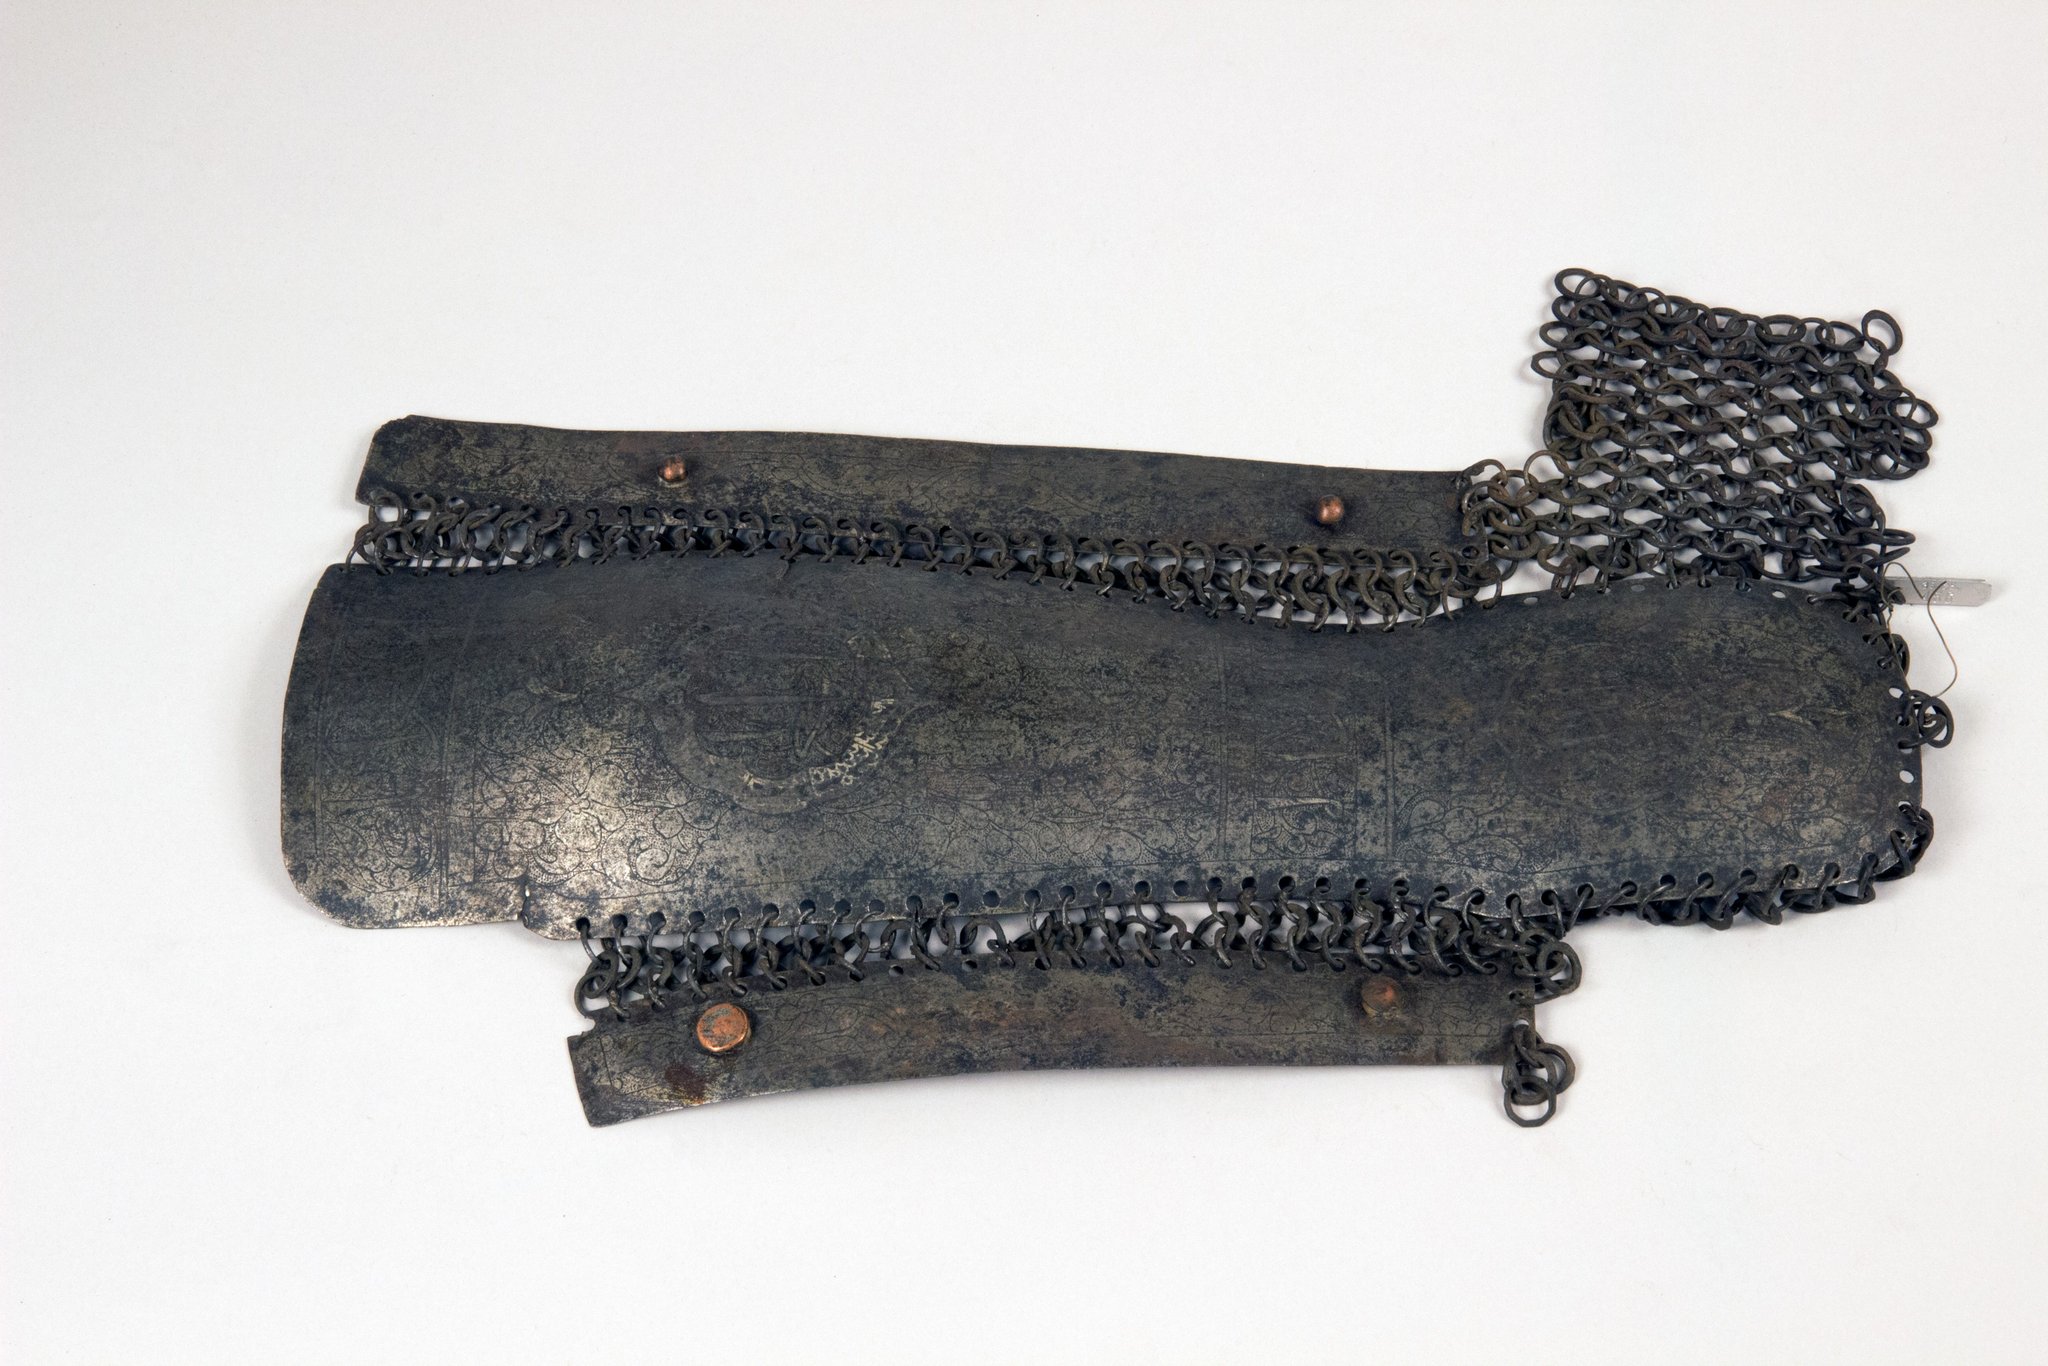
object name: leg guard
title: Left Leg Guard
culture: turkish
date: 1501-1600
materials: copper, silver, steel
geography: ottoman empire